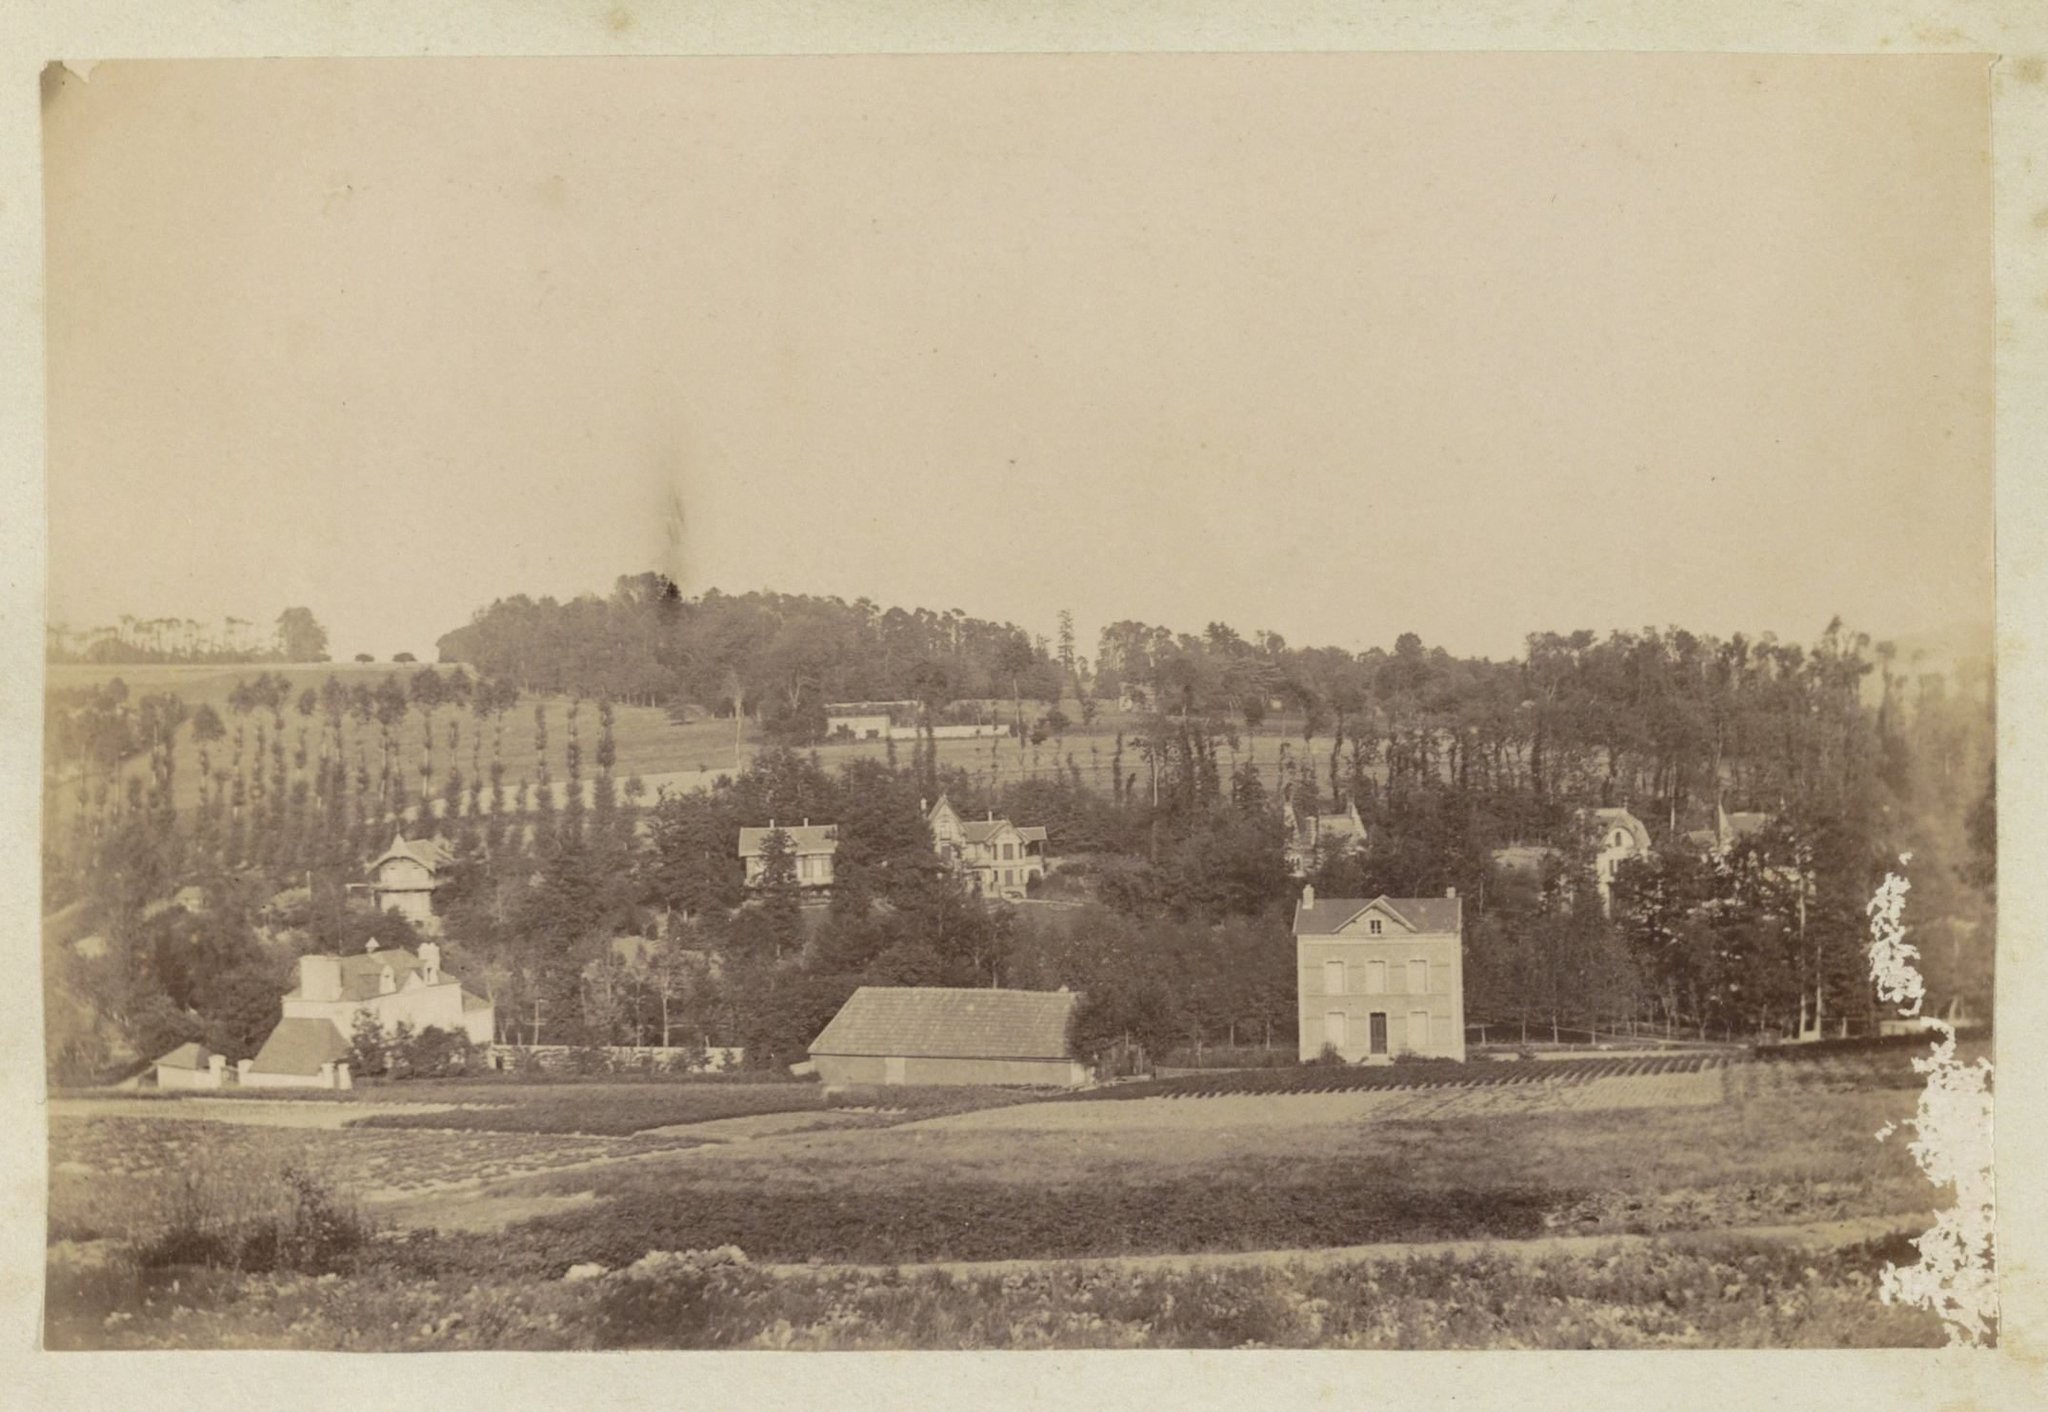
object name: photograph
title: Gezicht op een dorp met grote landhuizen in Frankrijk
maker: Anonymous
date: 1806-1884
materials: photographic support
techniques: albumen print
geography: france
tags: prospect of village, silhouette of village, rural housing, e.g. country-house, villa, cottage, france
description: Onderdeel van Album van een Franse amateurfotograaf met opnames van familie, militairen, industrie, landschappen en bezienswaardigheden in Frankrijk.